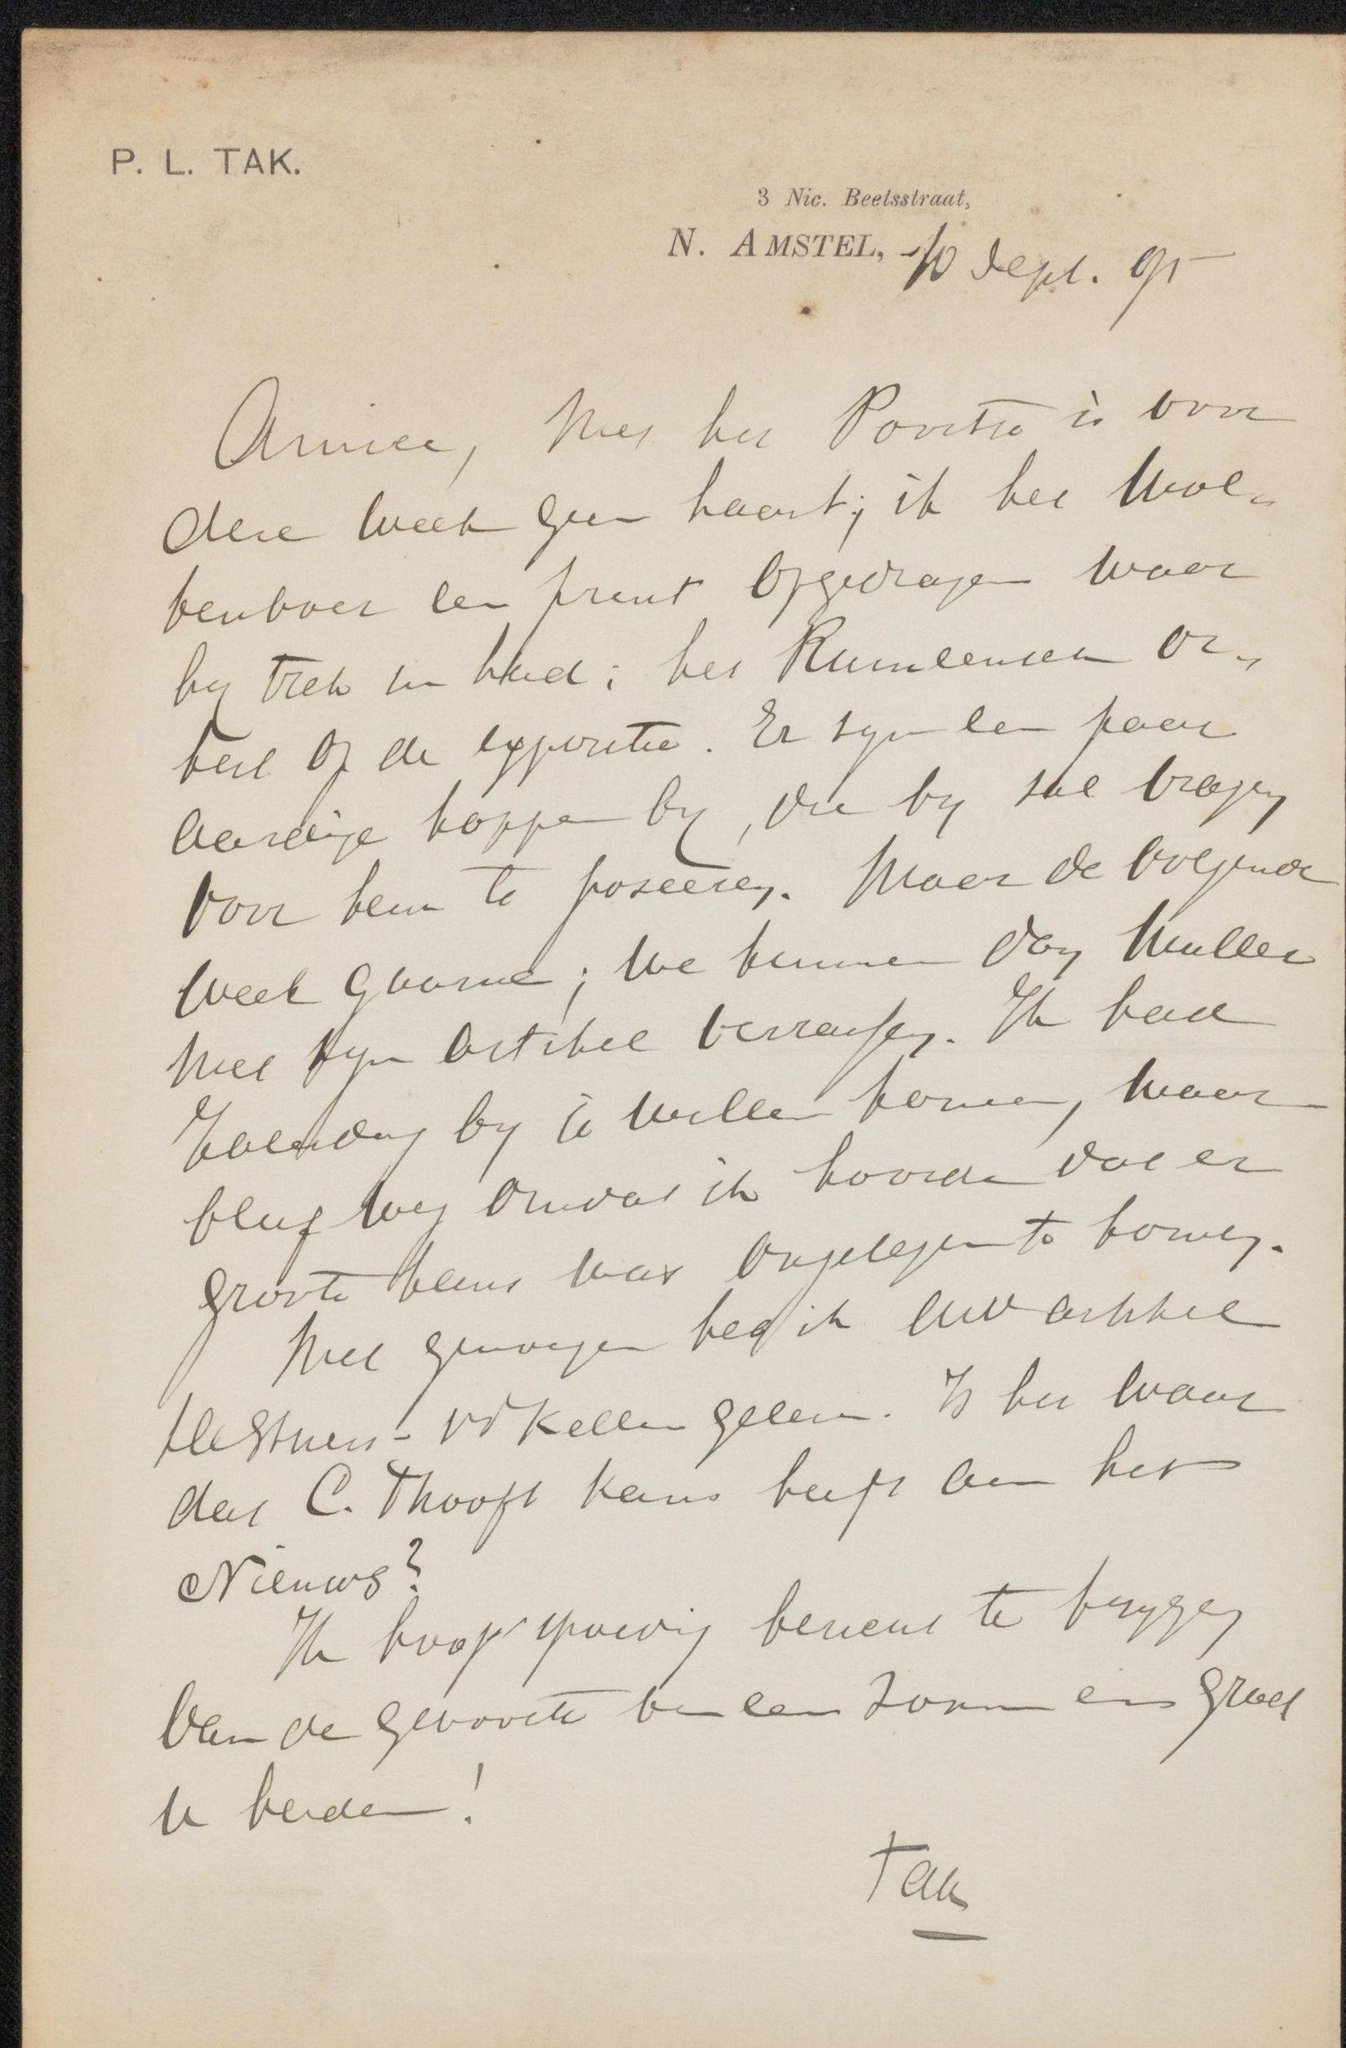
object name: letter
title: Brief aan Jan Veth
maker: pieter lodewijk tak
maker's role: politician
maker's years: 1848-1907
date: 1895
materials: ink, paper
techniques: pen, printing, writing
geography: nieuwer-amstel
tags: designer, jan veth, utrecht, johan philip van der kellen, maastricht, the hague, print maker, draughtsman, jonkheer victor eugène louis de stuers, haarlem, anton molkenboer, amsterdam, painter, cornelis gerardus 't hooft, the graphic arts, printed matter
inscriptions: collector's mark: ‘RPK’, watermark